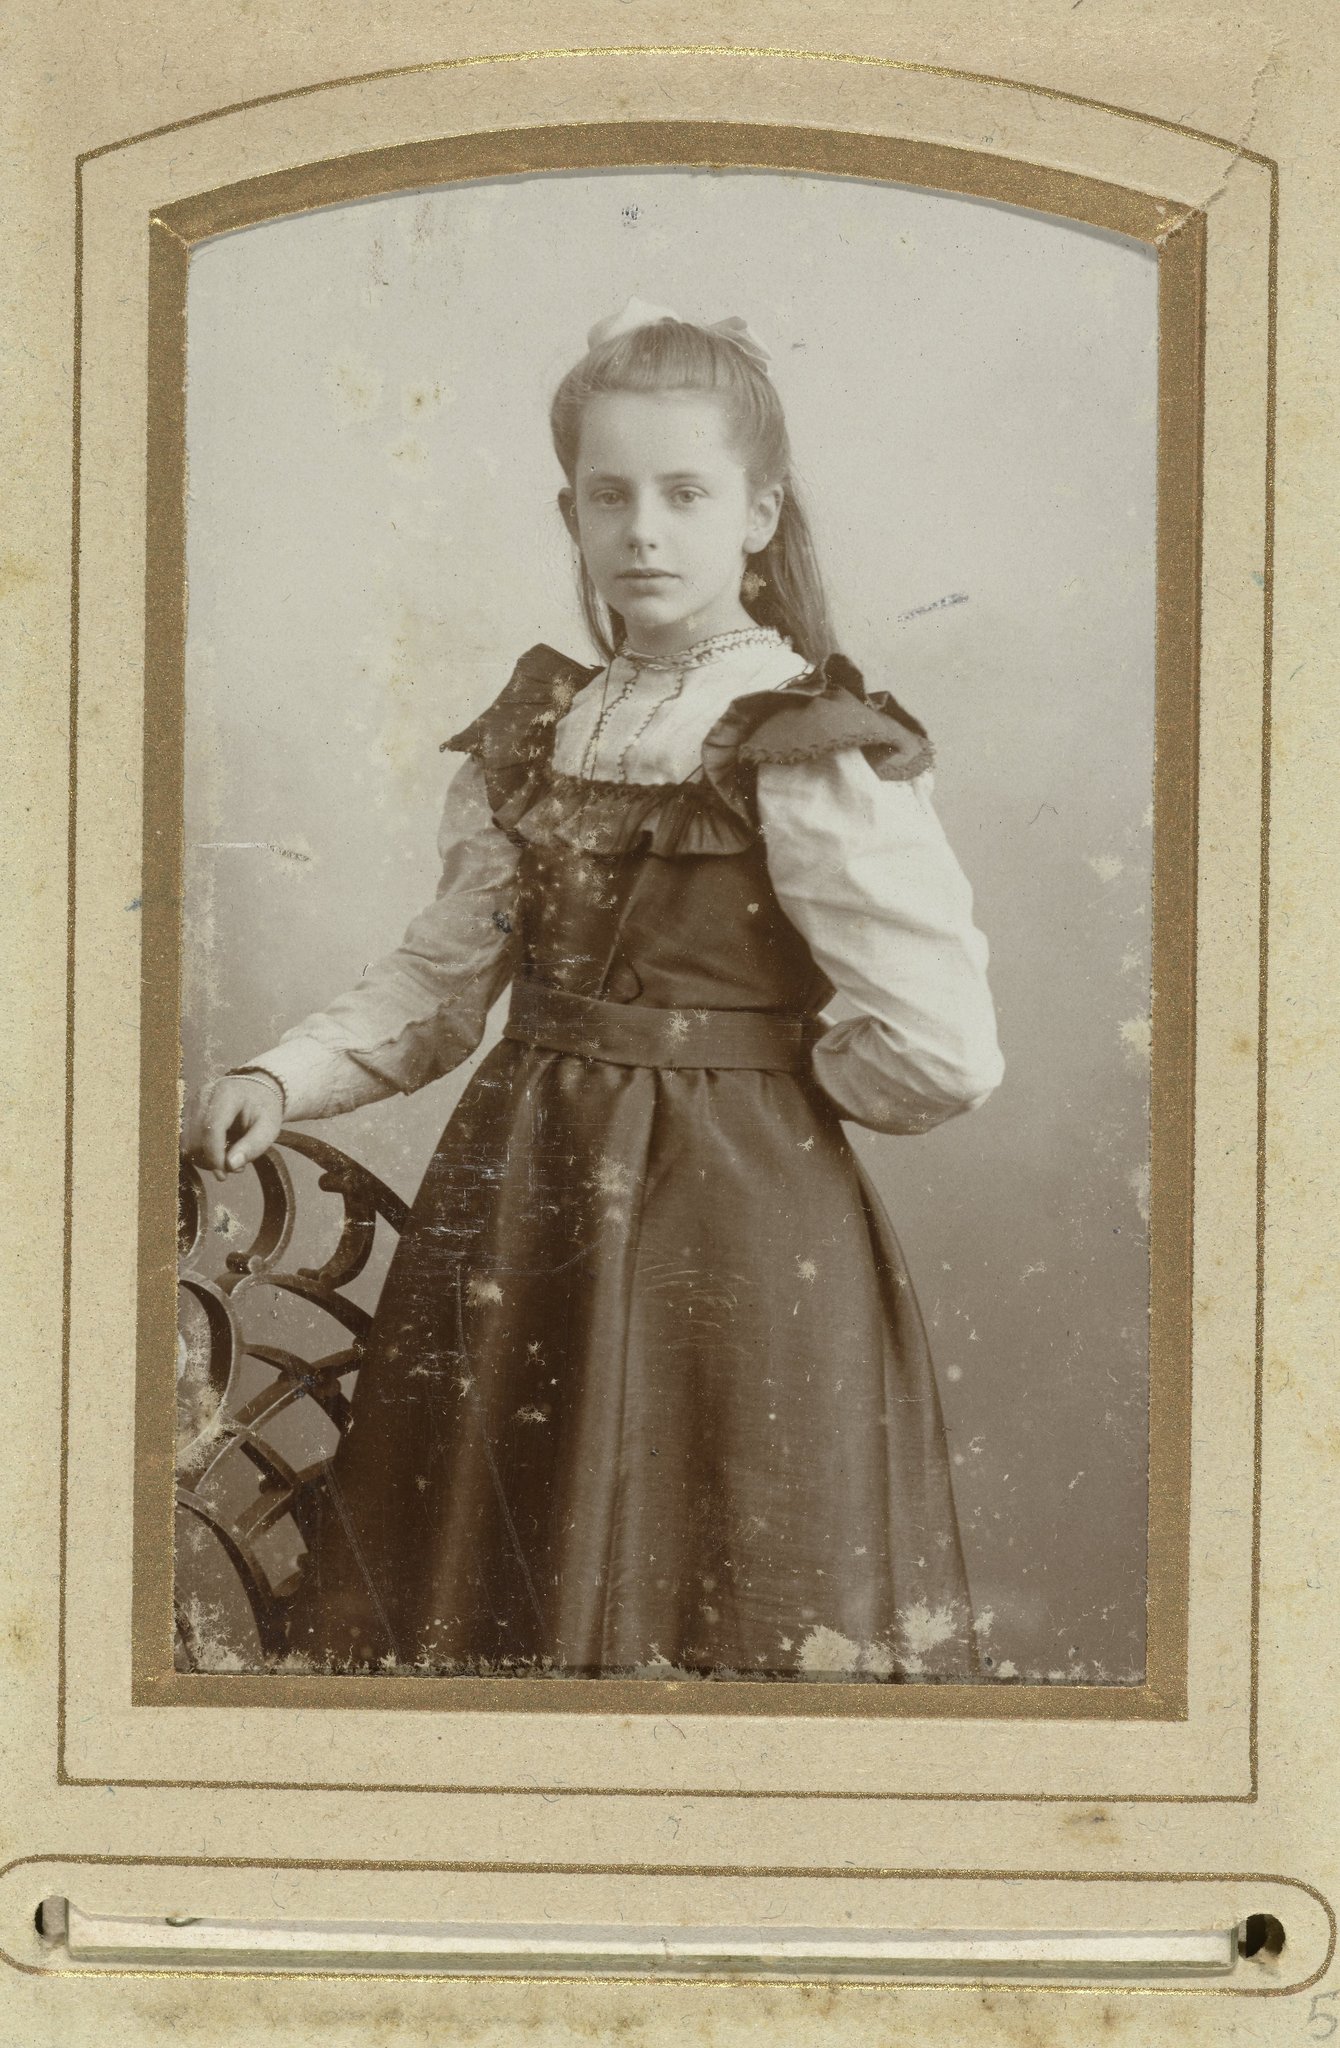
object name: photograph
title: Portret van een meisje in een donkere jurk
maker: cornelis johannes lodewicus vermeulen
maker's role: fotograaf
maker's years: 1861-1936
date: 1890-1910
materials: paper, photographic support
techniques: photography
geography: the hague